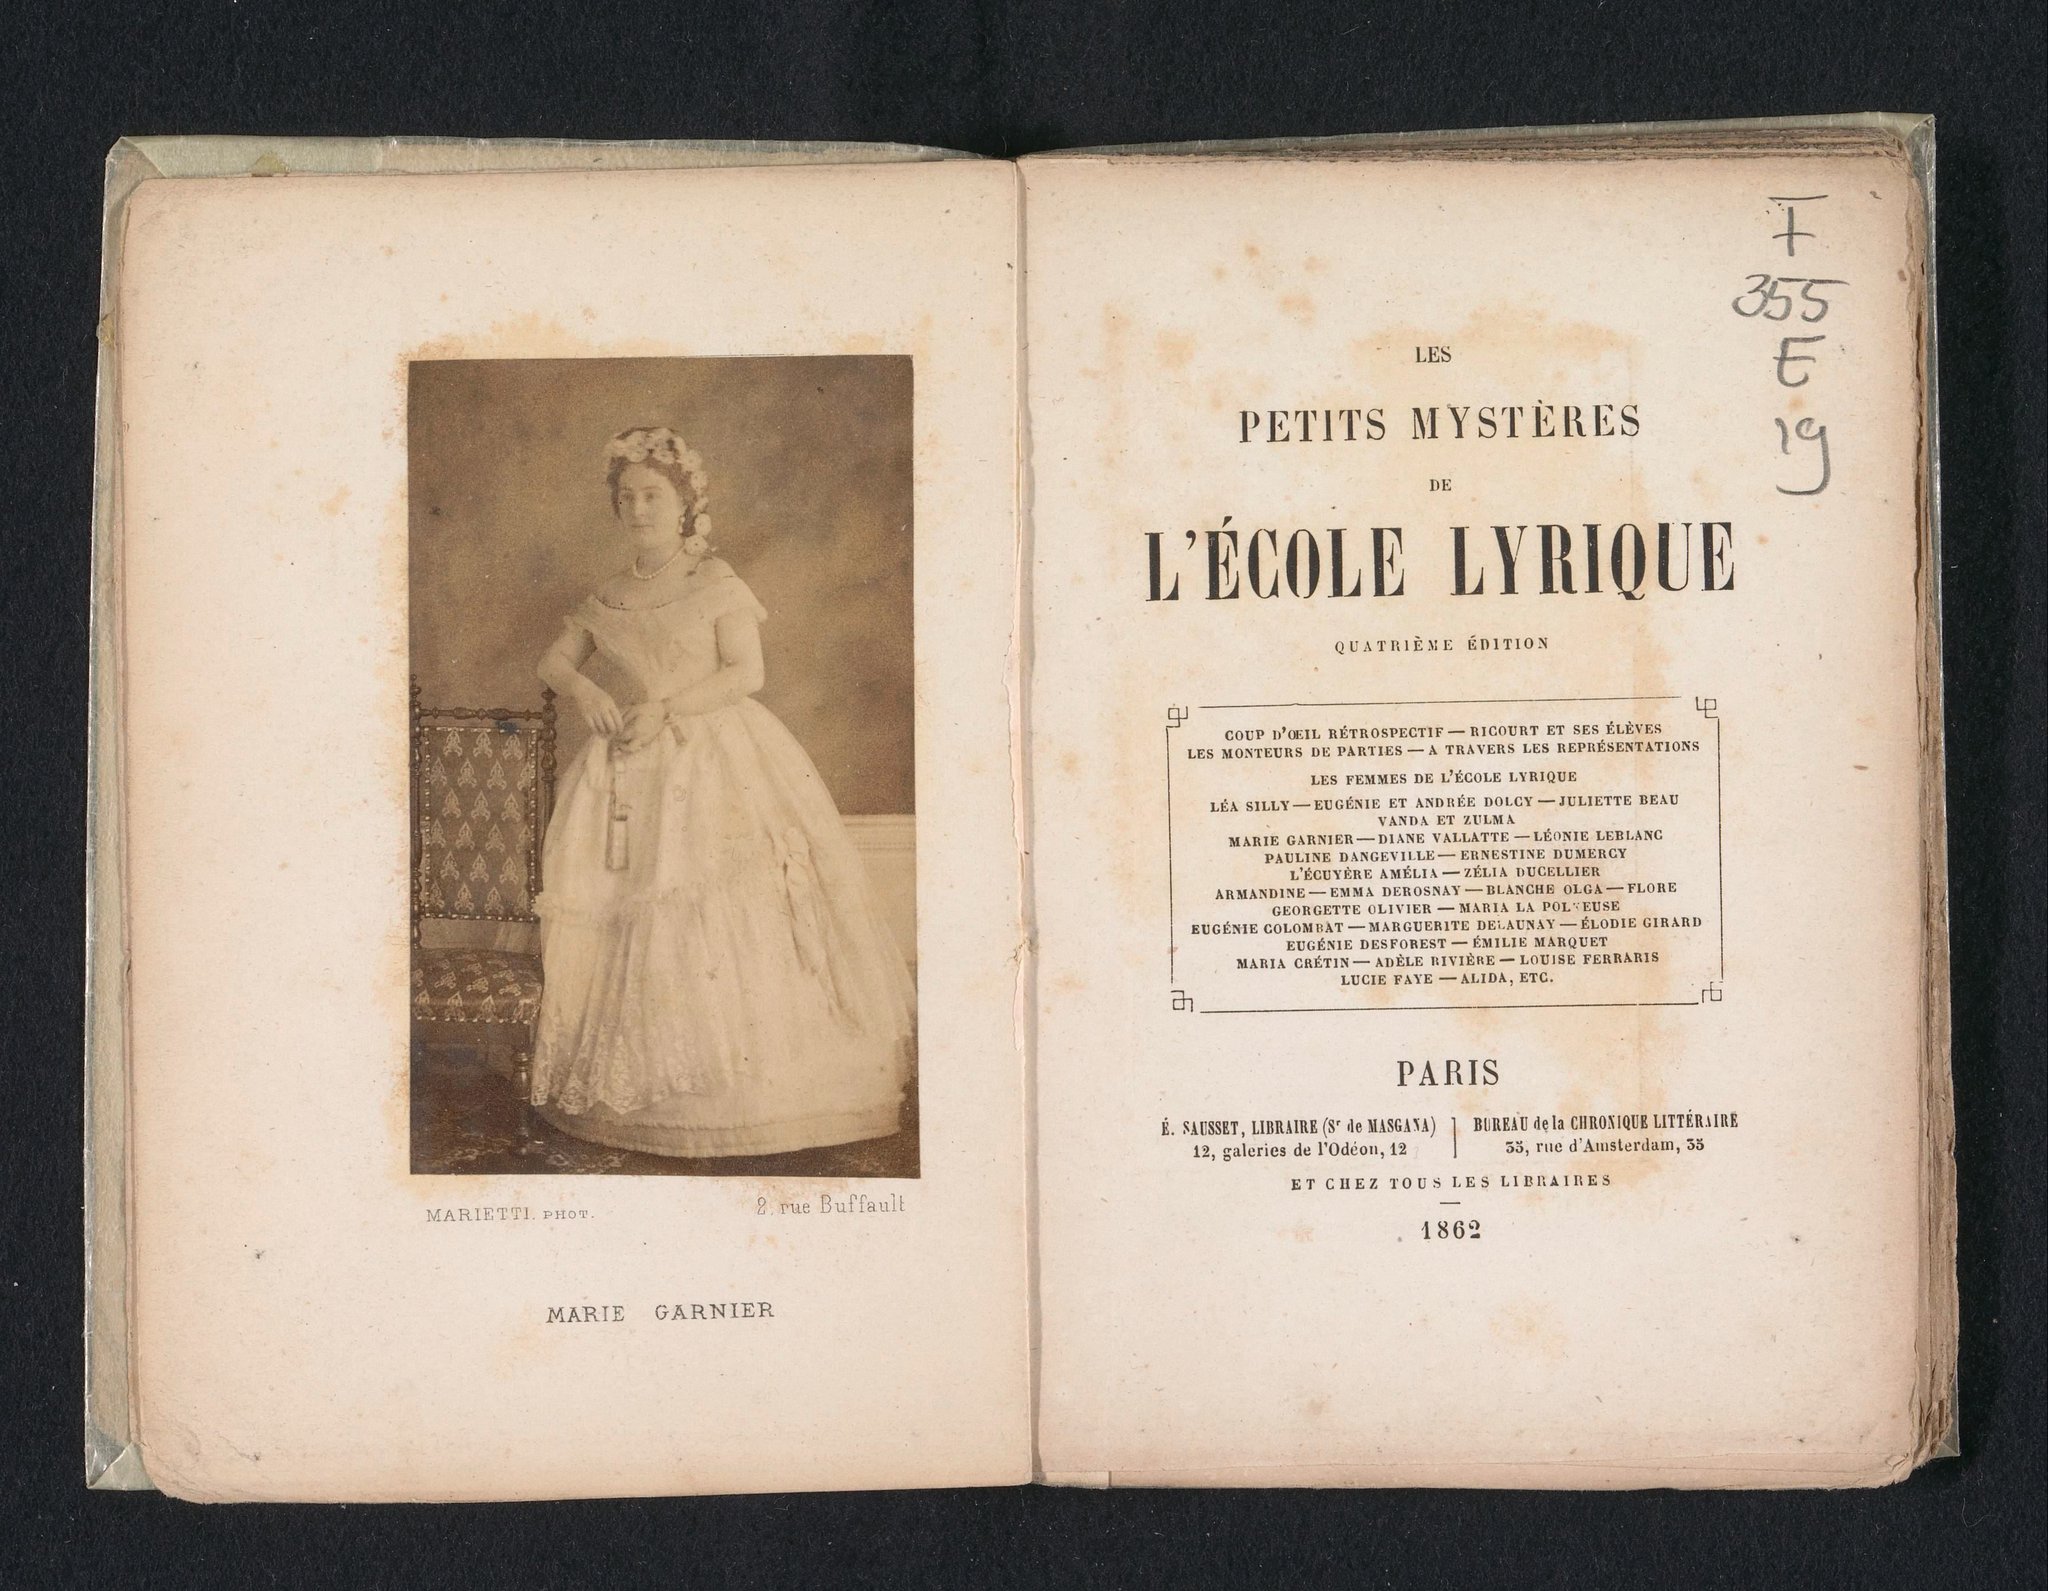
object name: book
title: Les petits mystères de l'école lyrique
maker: é. sausset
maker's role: publisher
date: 1862-1863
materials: paper, photographic support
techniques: albumen print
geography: paris